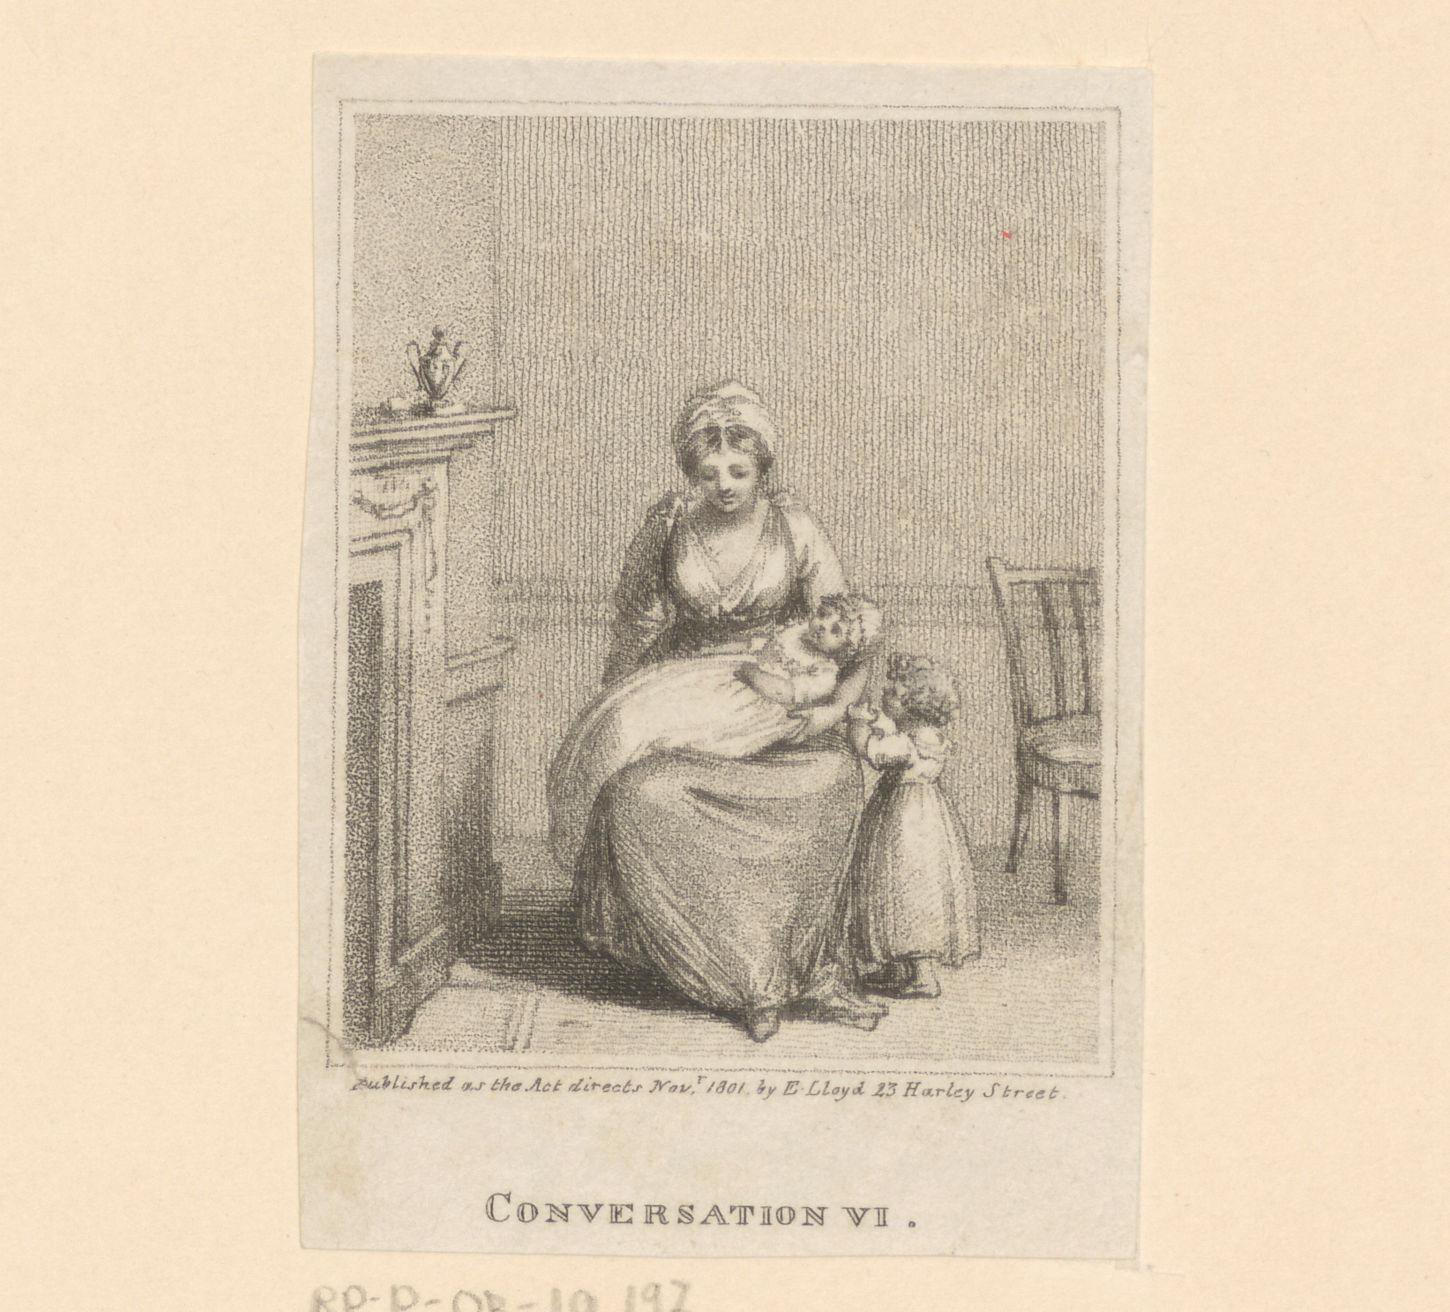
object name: print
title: Vrouw zit met twee kinderen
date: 1801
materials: paper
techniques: etching, soft ground etching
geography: london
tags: taking care of children, child (at home)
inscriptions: collector's mark: Lugt 2228